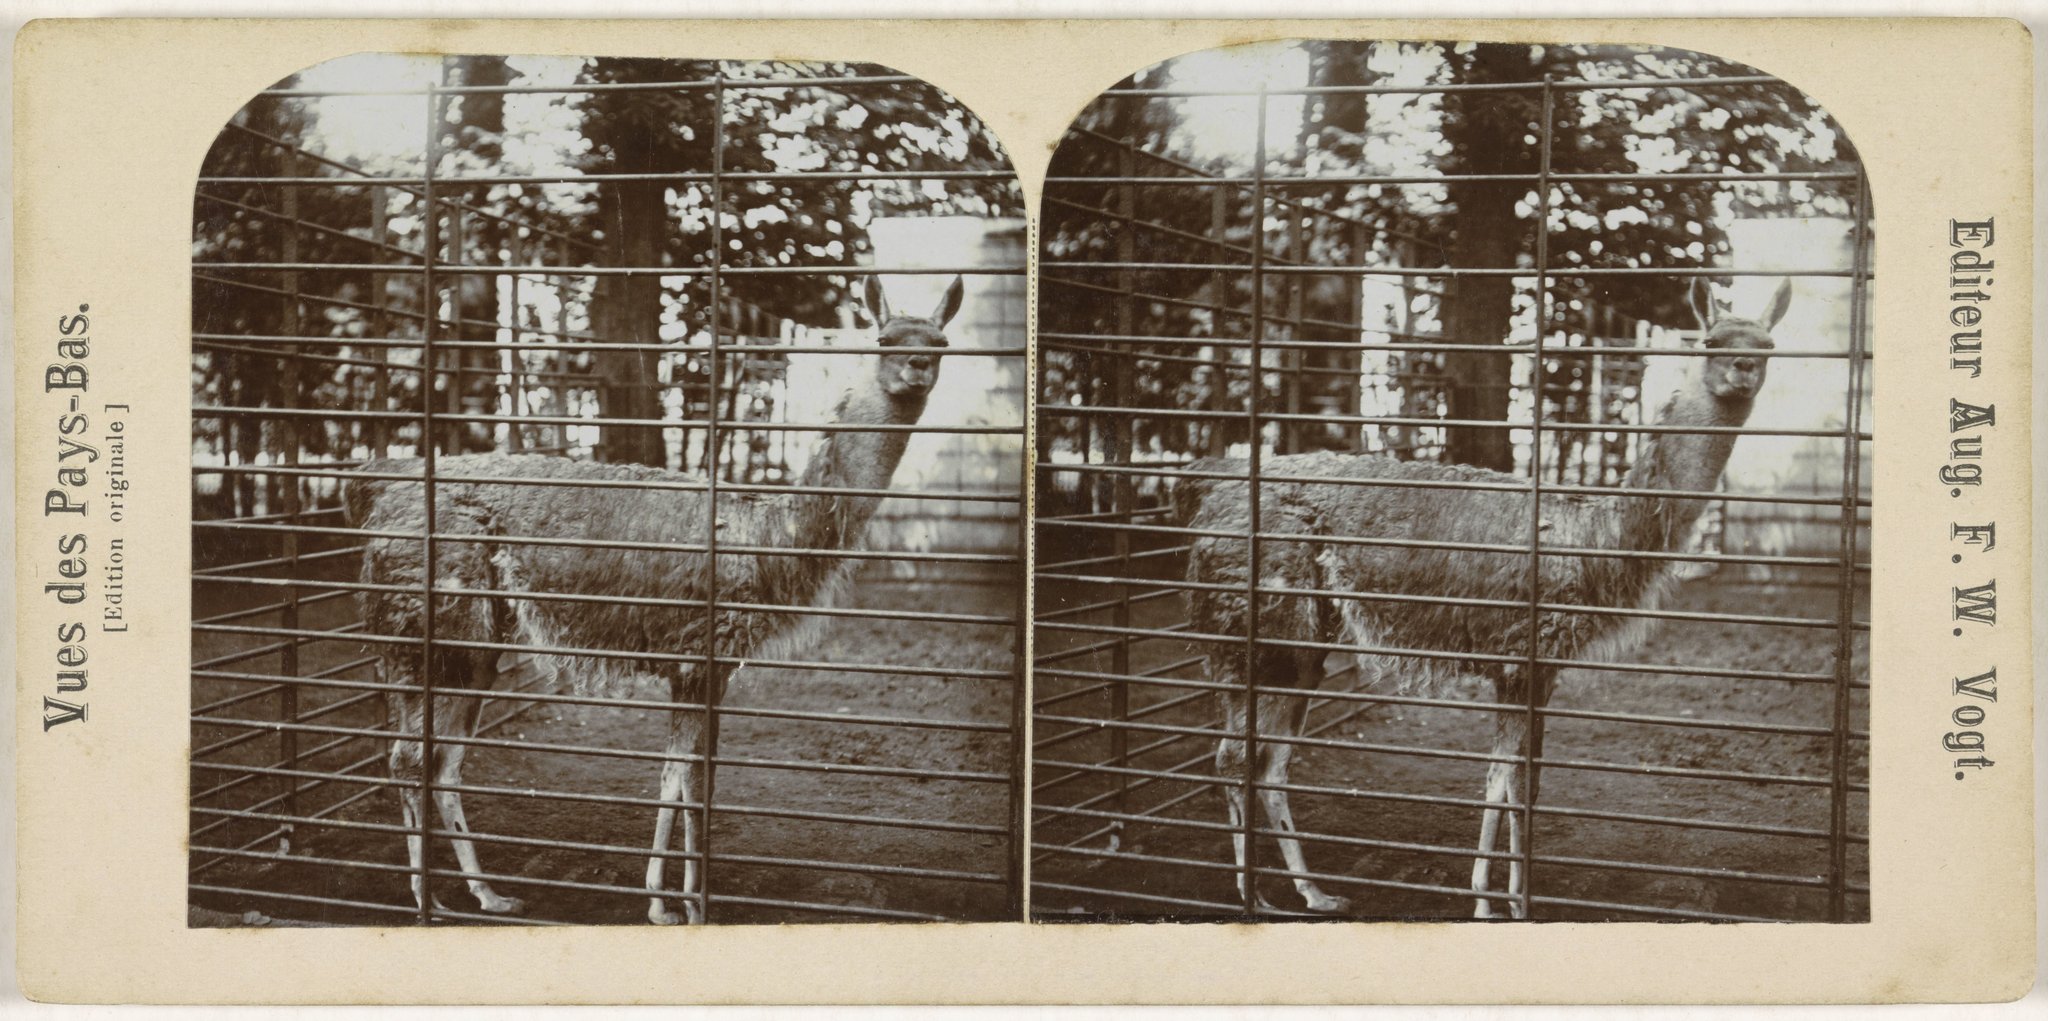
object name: stereograph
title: Lama in dierentuin (Artis?), Nederland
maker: august frederik willem vogt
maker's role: fotograaf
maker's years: 1871-1922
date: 1920-1940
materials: cardboard, paper, photographic support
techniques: collodion silver print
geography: netherlands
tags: netherlands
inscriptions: inscription: ‘€7,50’